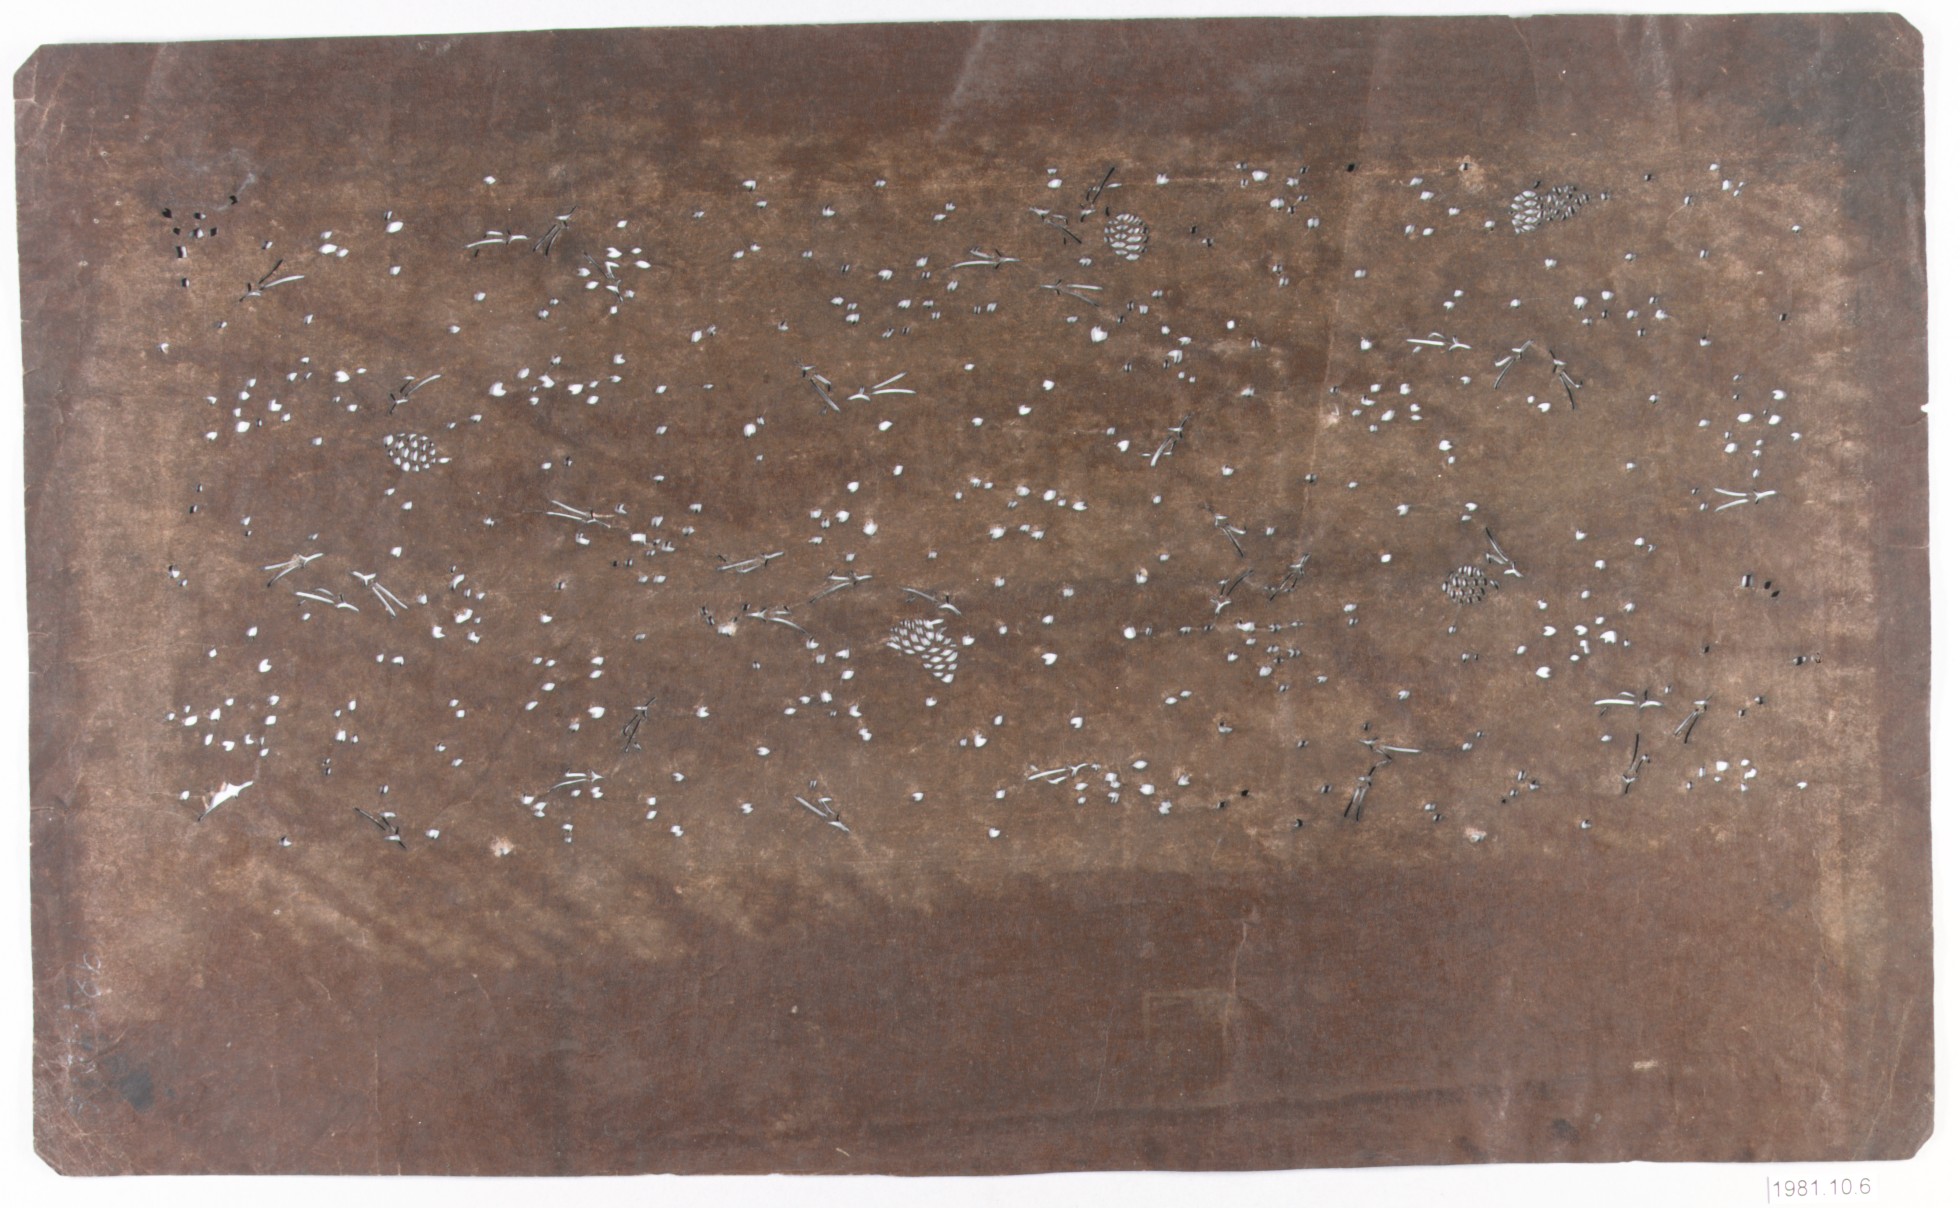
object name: stencil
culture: japanese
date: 1801-1900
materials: paper